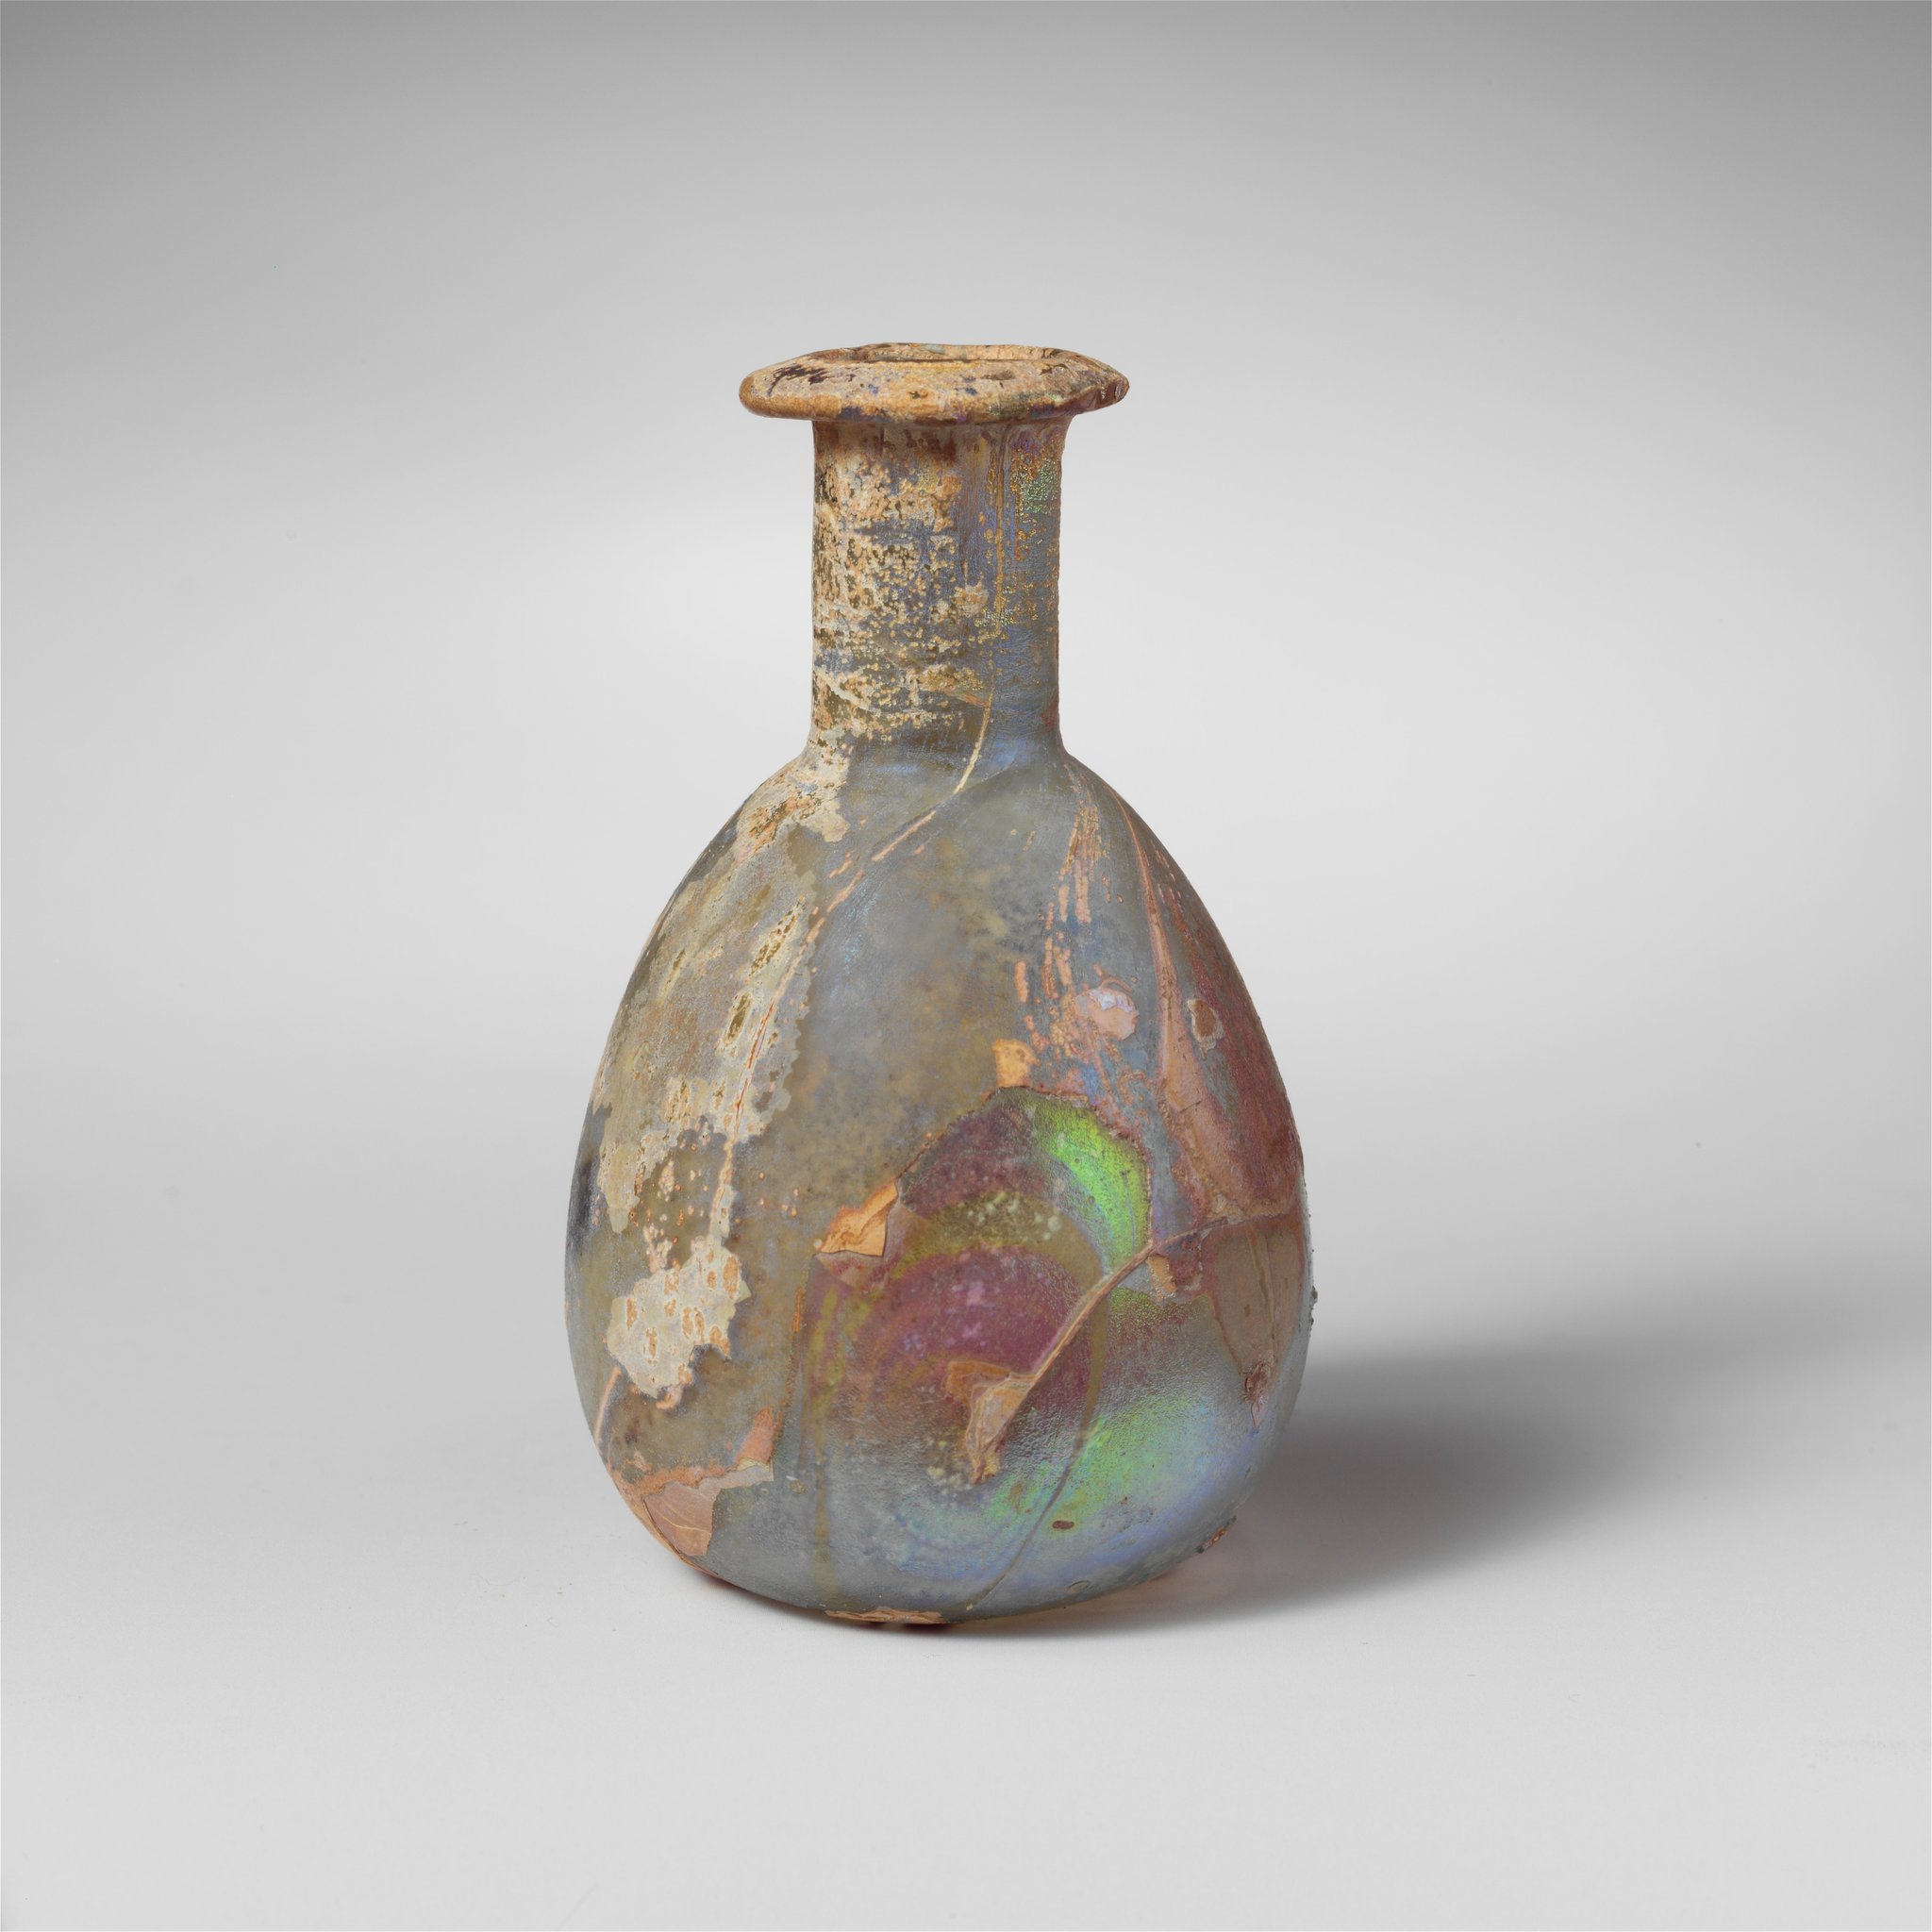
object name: perfume bottle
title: Glass perfume bottle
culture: roman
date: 1-100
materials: glass